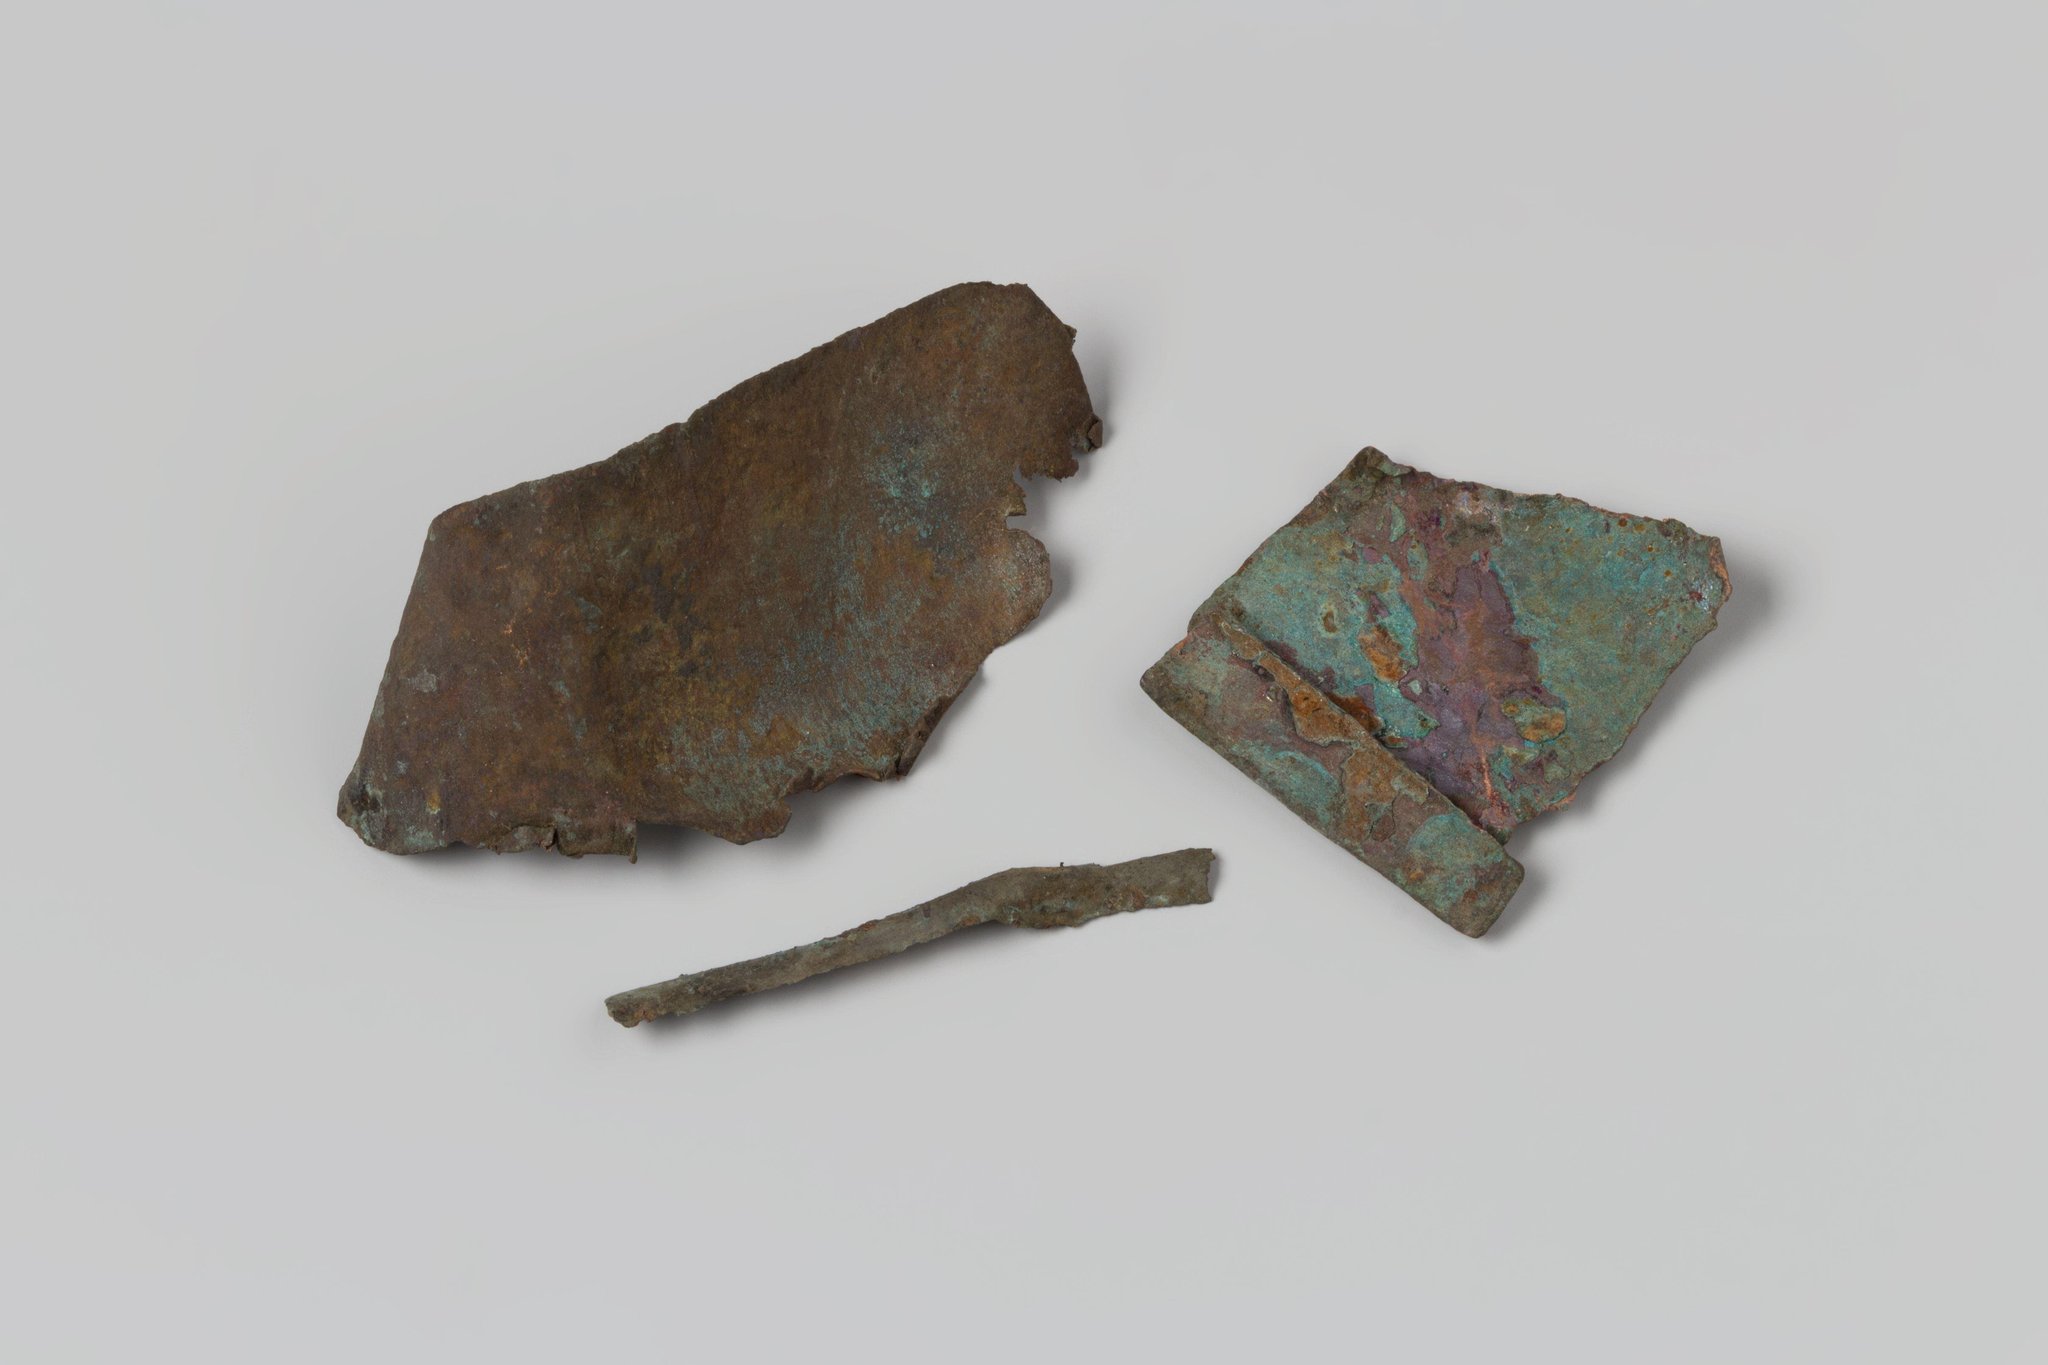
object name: scheepswrakvondst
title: Fragmenten van koper uit het wrak van de Oost-Indiëvaarder Hollandia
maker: Anonymous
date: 1700-1743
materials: copper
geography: netherlands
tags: verenigde oostindische compagnie, hollandia (schip), annet